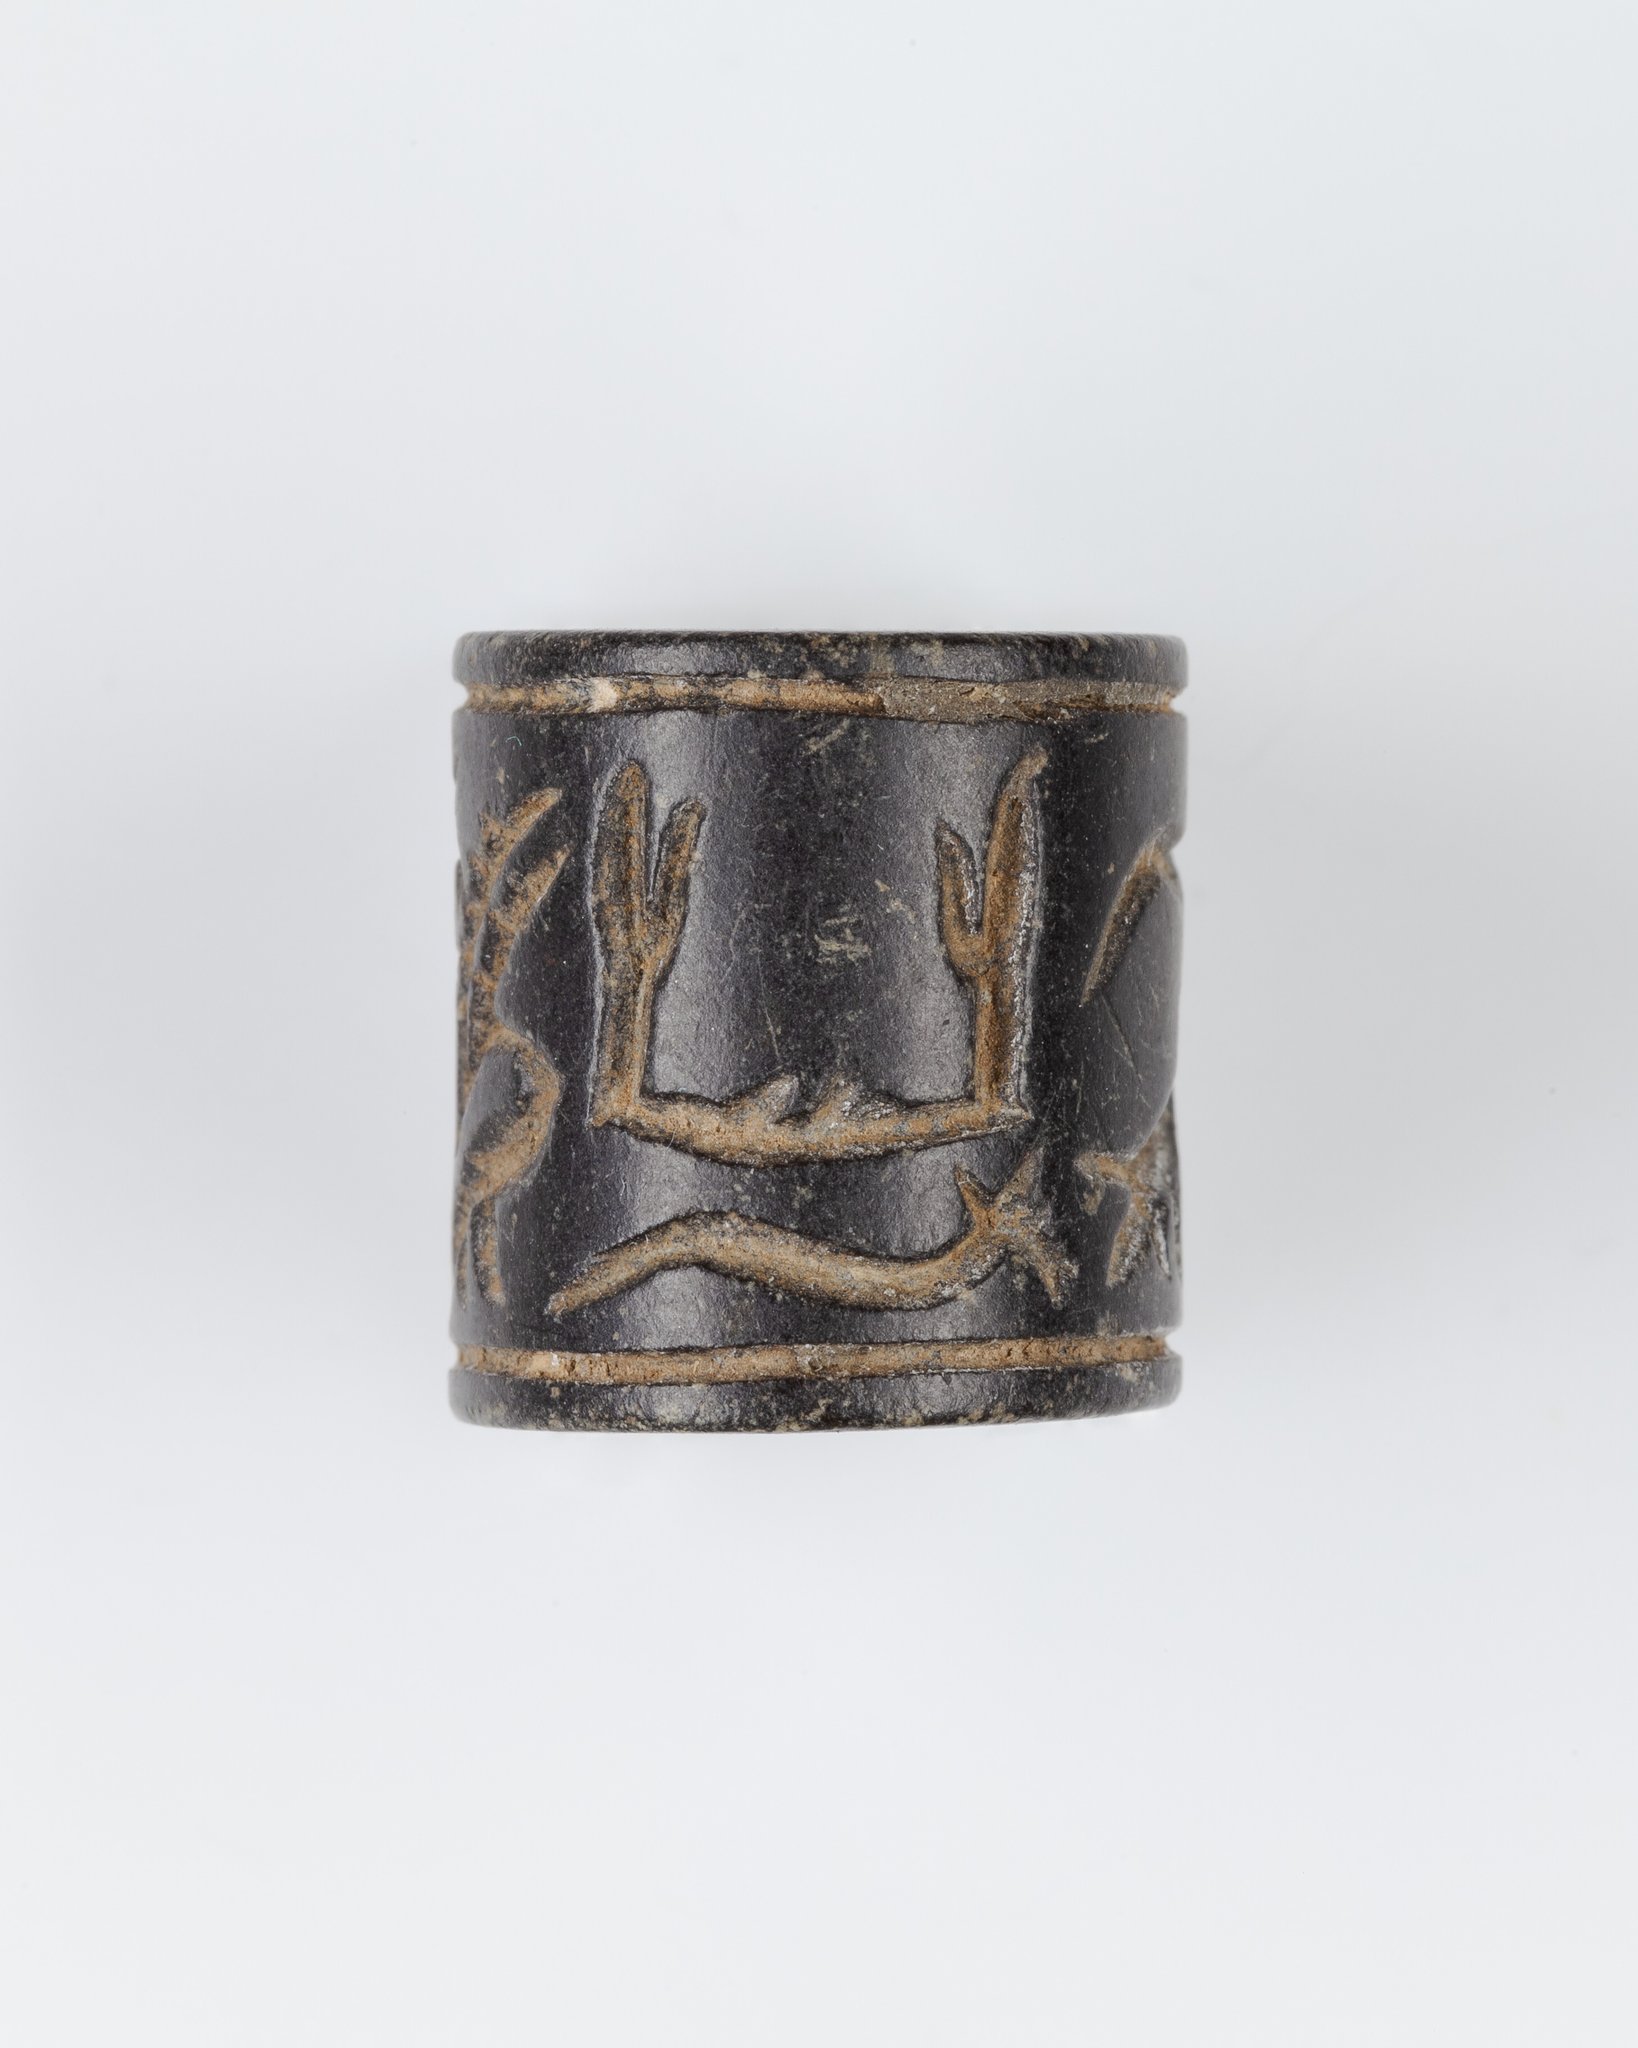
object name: cylinder seal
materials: stone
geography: egypt